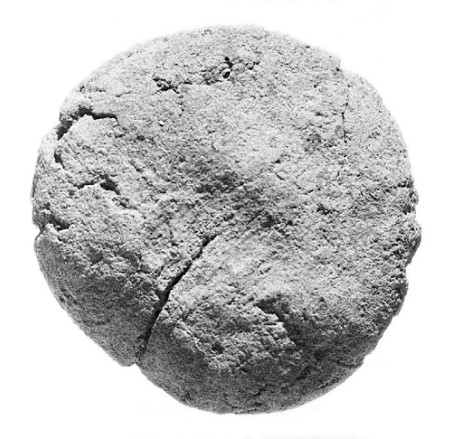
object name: sealing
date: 1981-1640 BCE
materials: mud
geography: egypt